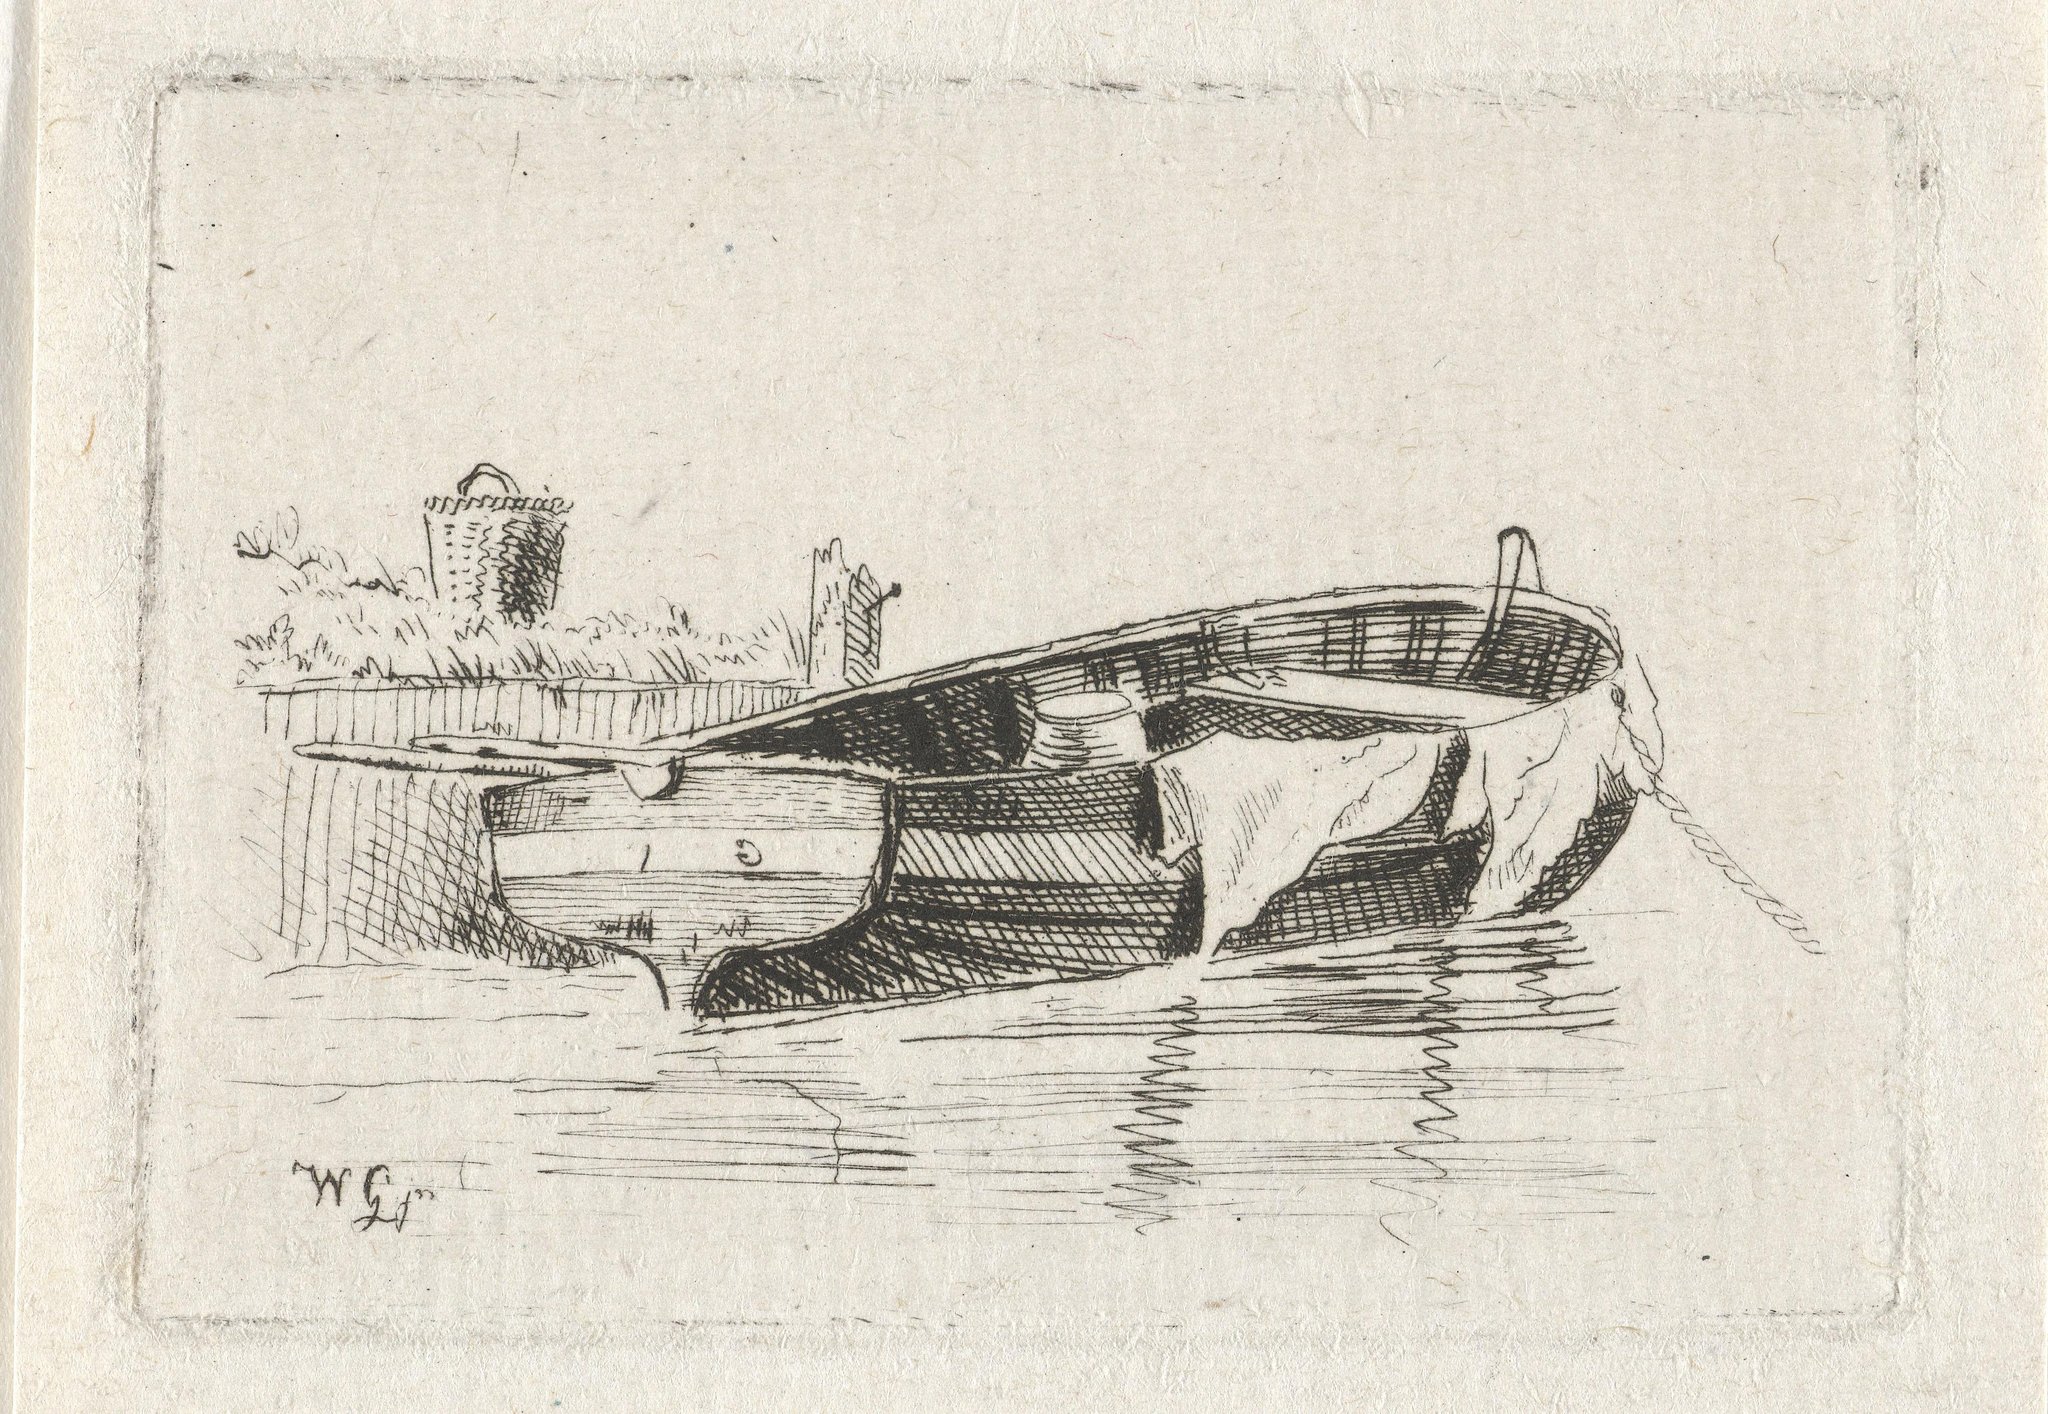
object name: print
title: Aangemeerde roeiboot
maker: willem gruyter jr.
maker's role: draughtsman, print maker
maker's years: 1817-1880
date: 1832-1880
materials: paper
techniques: etching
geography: amsterdam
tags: rowing-boat, canoe, etc.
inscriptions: collector's mark: Lugt 2165